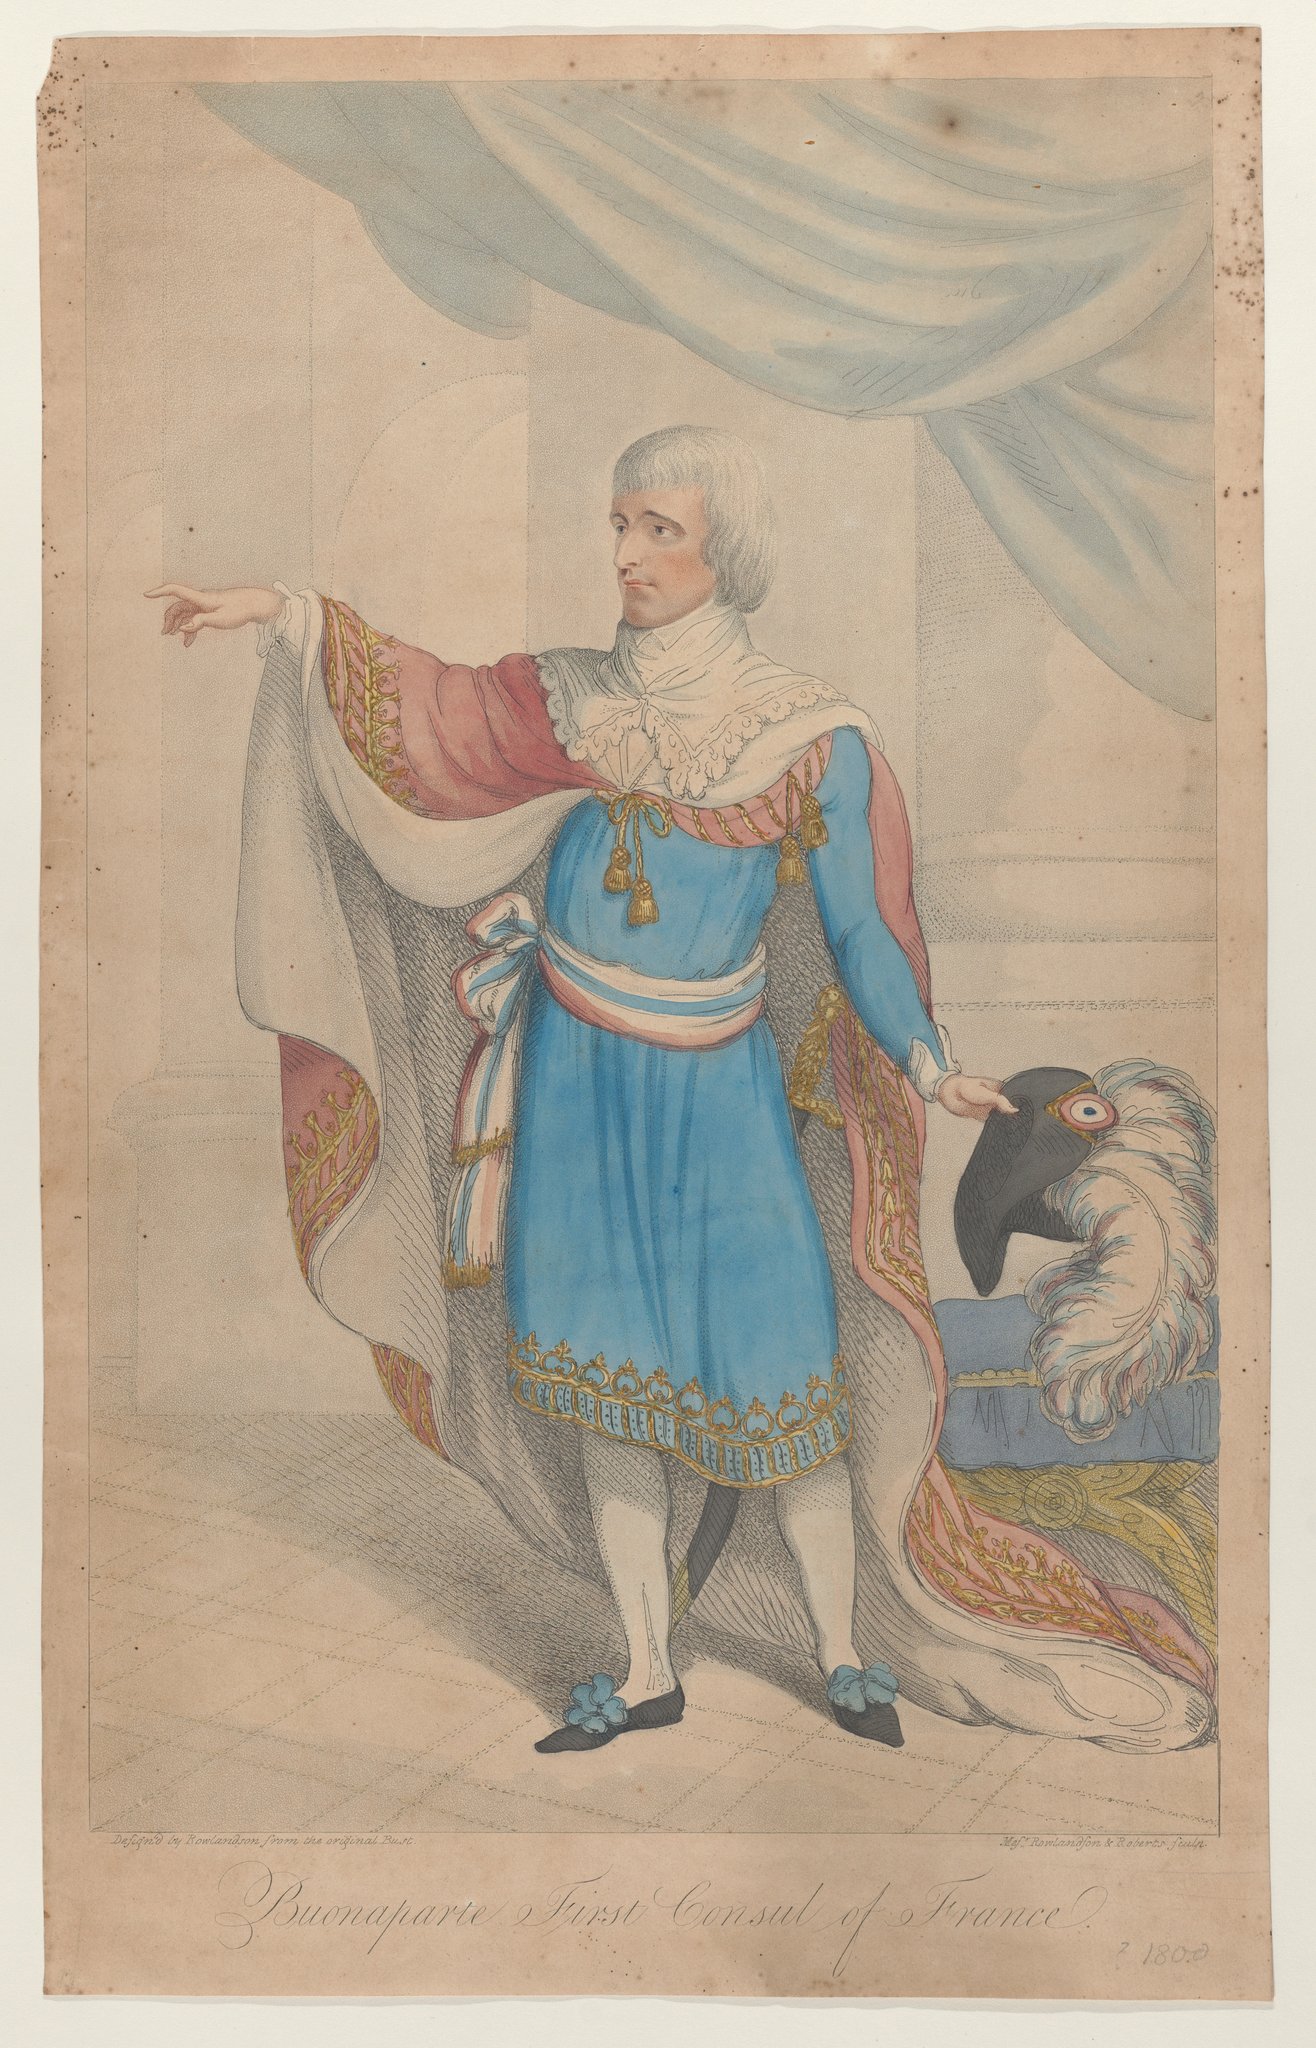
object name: print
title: Buonaparte First Consul of France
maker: thomas rowlandson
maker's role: artist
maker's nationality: british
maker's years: 1757-1827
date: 1800-1804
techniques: aquatint, etching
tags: napoleon i,men